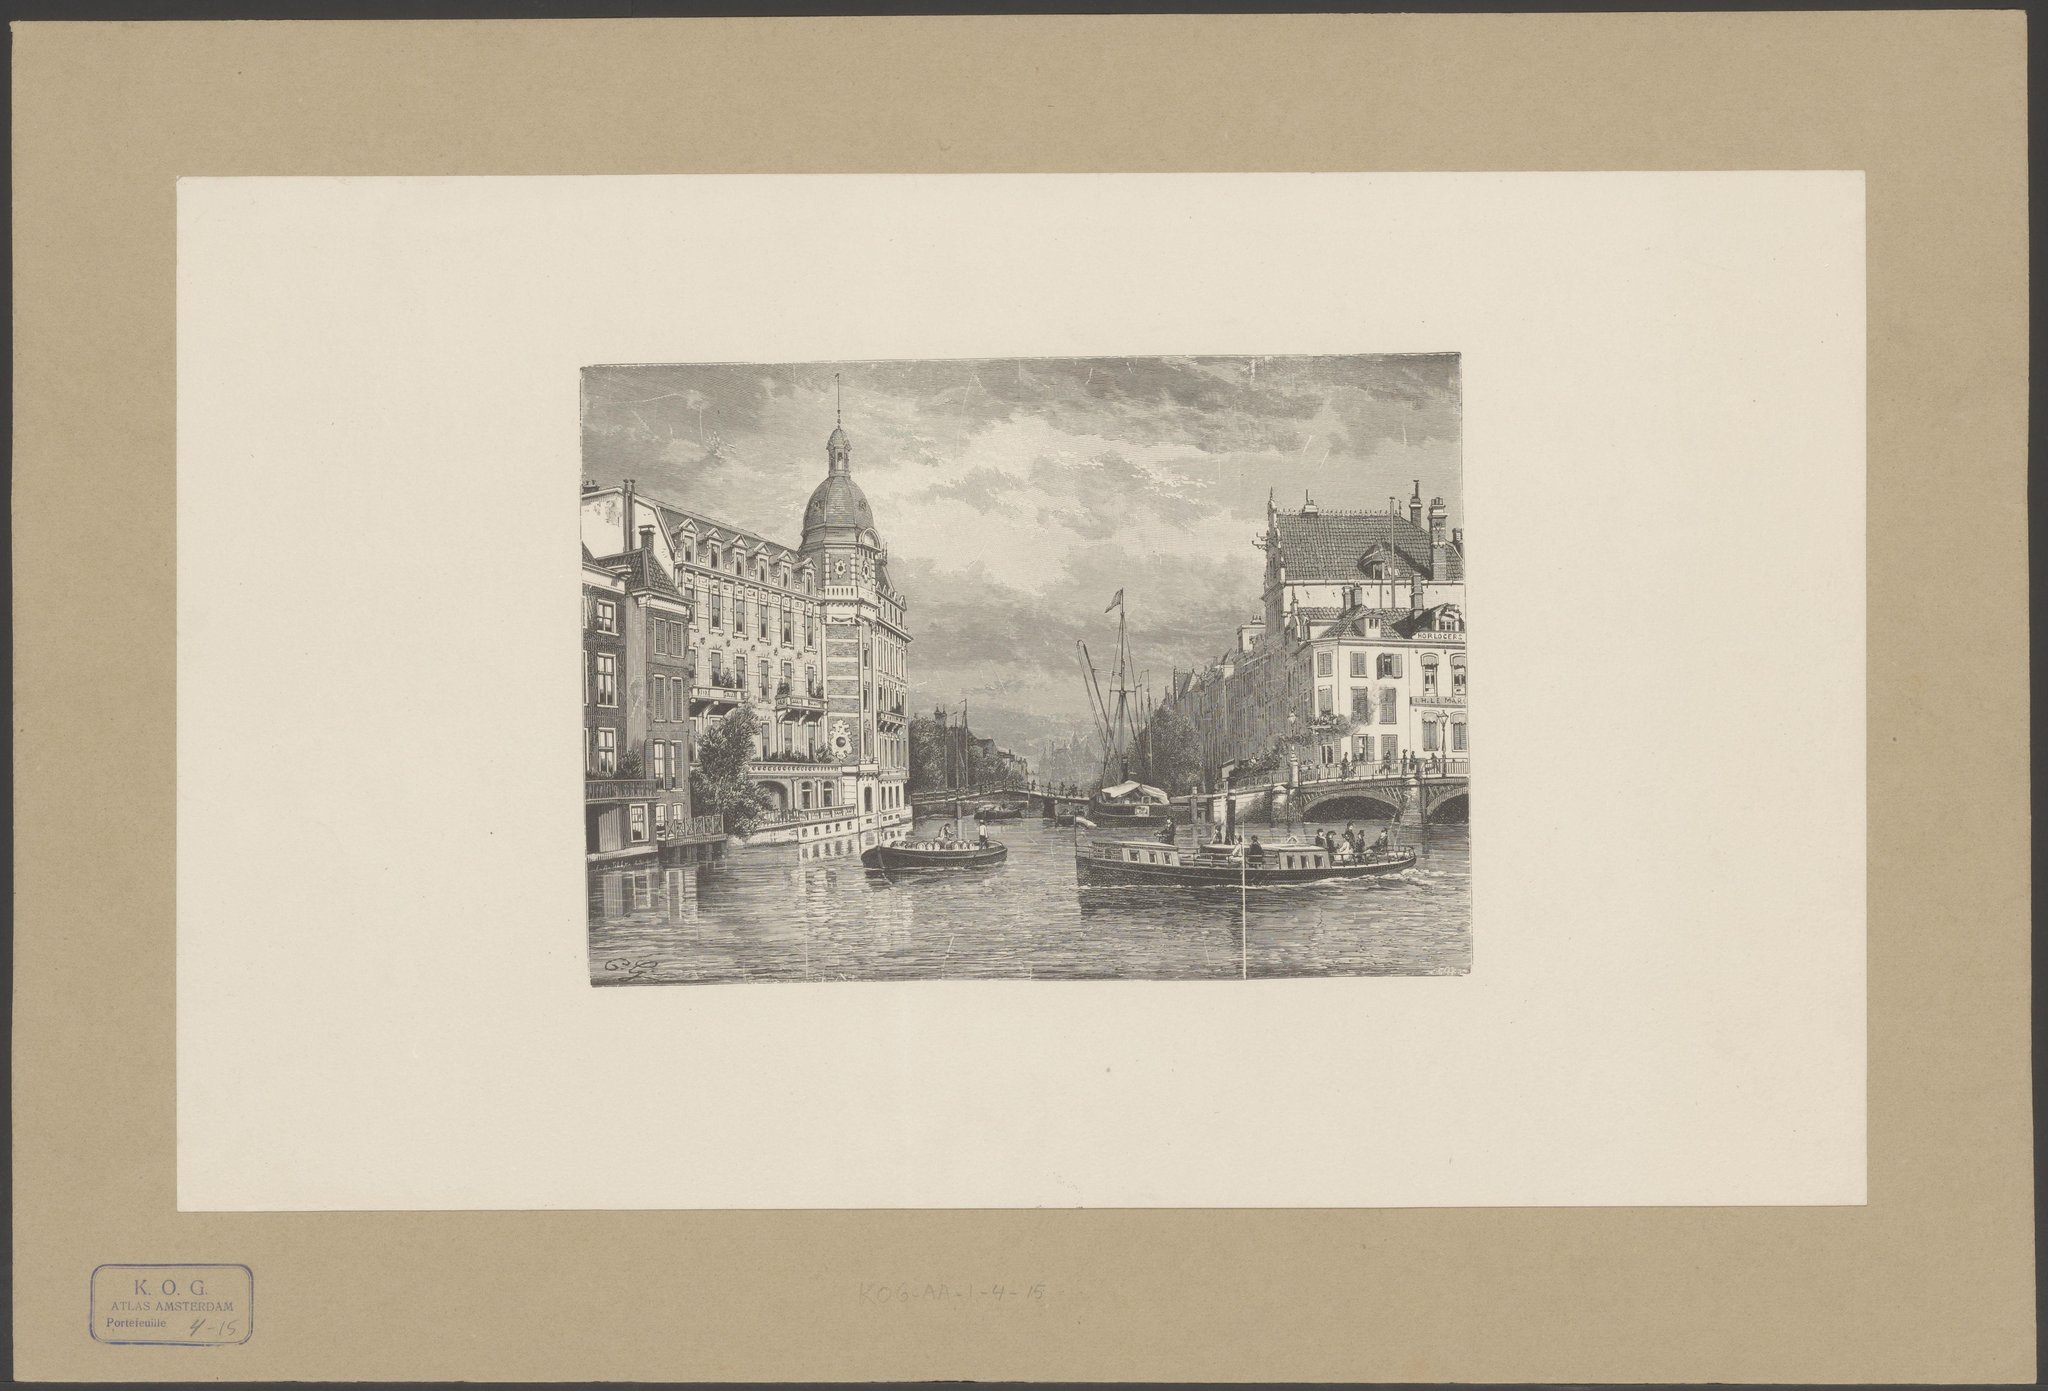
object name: print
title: Gezicht op het Doelenhotel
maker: Anonymous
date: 1883-1899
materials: paper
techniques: engraving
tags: city-view in general; 'veduta', canal, bridge in city across river, canal, etc., hotel, hostelry, inn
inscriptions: collector's mark: ‘4-15’ Lugt 1641b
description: Onderwerpsrubriek binnen de Atlas Amsterdam: Amstel van Doelensluis tot Blauwbrug.